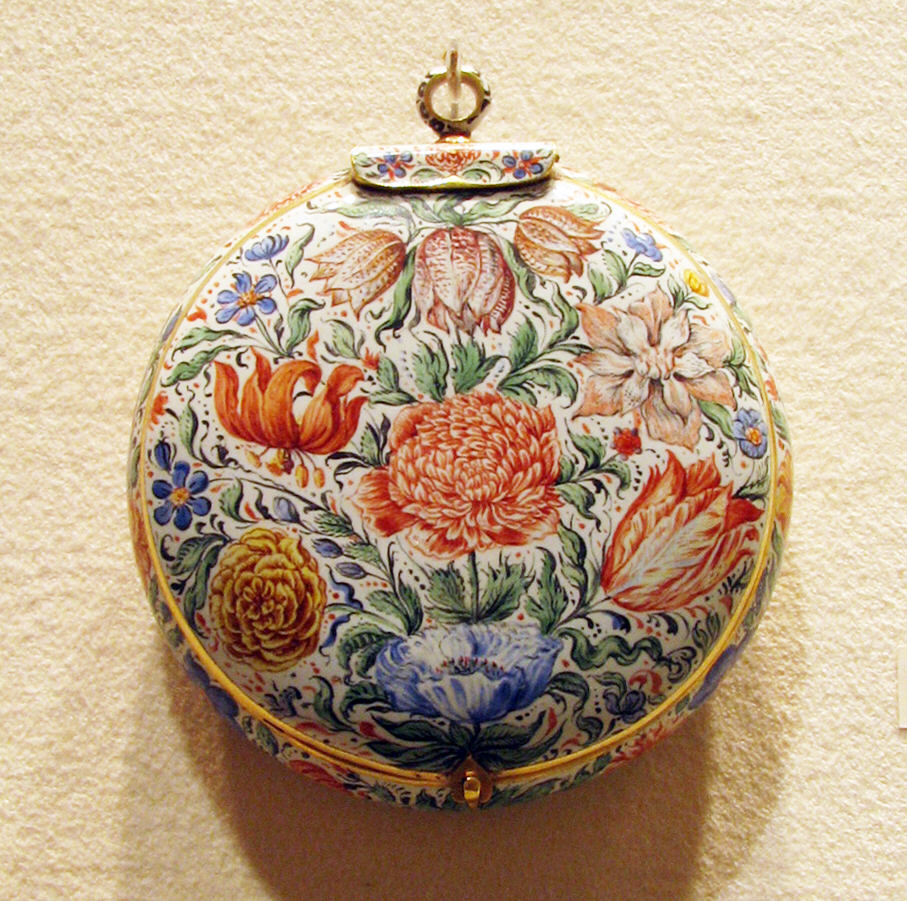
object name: watch case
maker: christophe morliêre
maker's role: enameler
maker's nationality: french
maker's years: 1600-1700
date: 1645-1650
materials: enamel, metal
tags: flowers,madonna and child,crowd